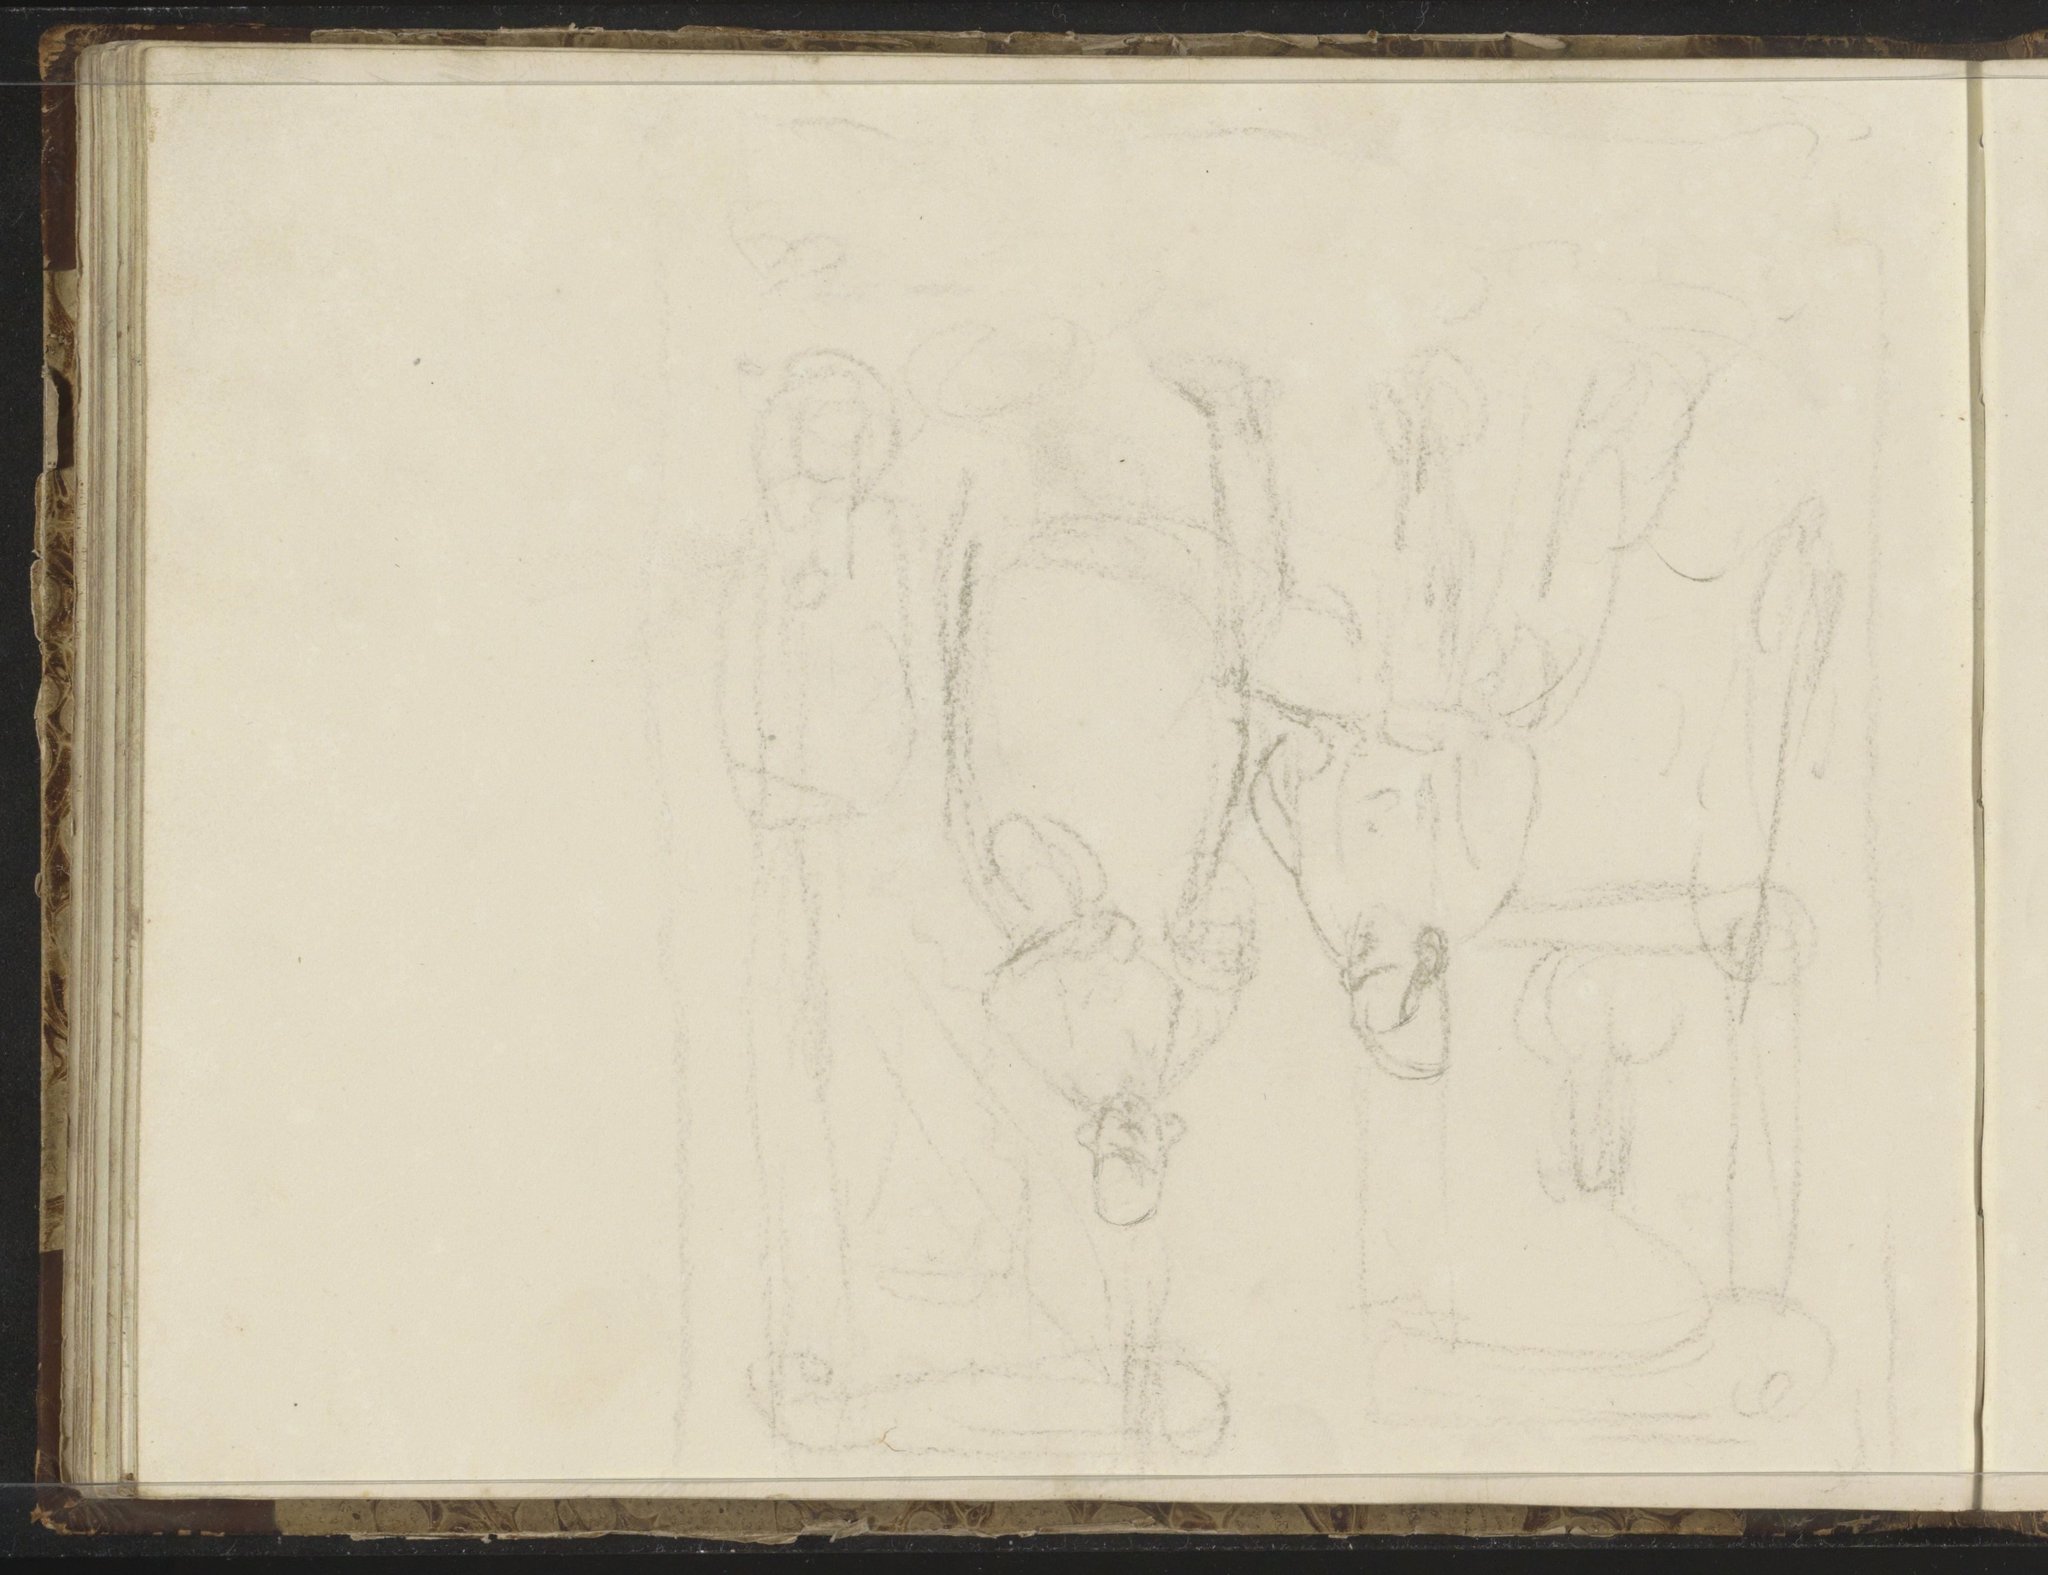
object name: sketchbook leaf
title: Boereninterieur met een twee figuren bij een venster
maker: willem hendrik schmidt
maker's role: draughtsman, painter, print maker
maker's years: 1809-1849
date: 1819-1849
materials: chalk, paper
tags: cottage - aa - civic architecture: inside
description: Blad 43 verso uit een schetsboek met 52 bladen.